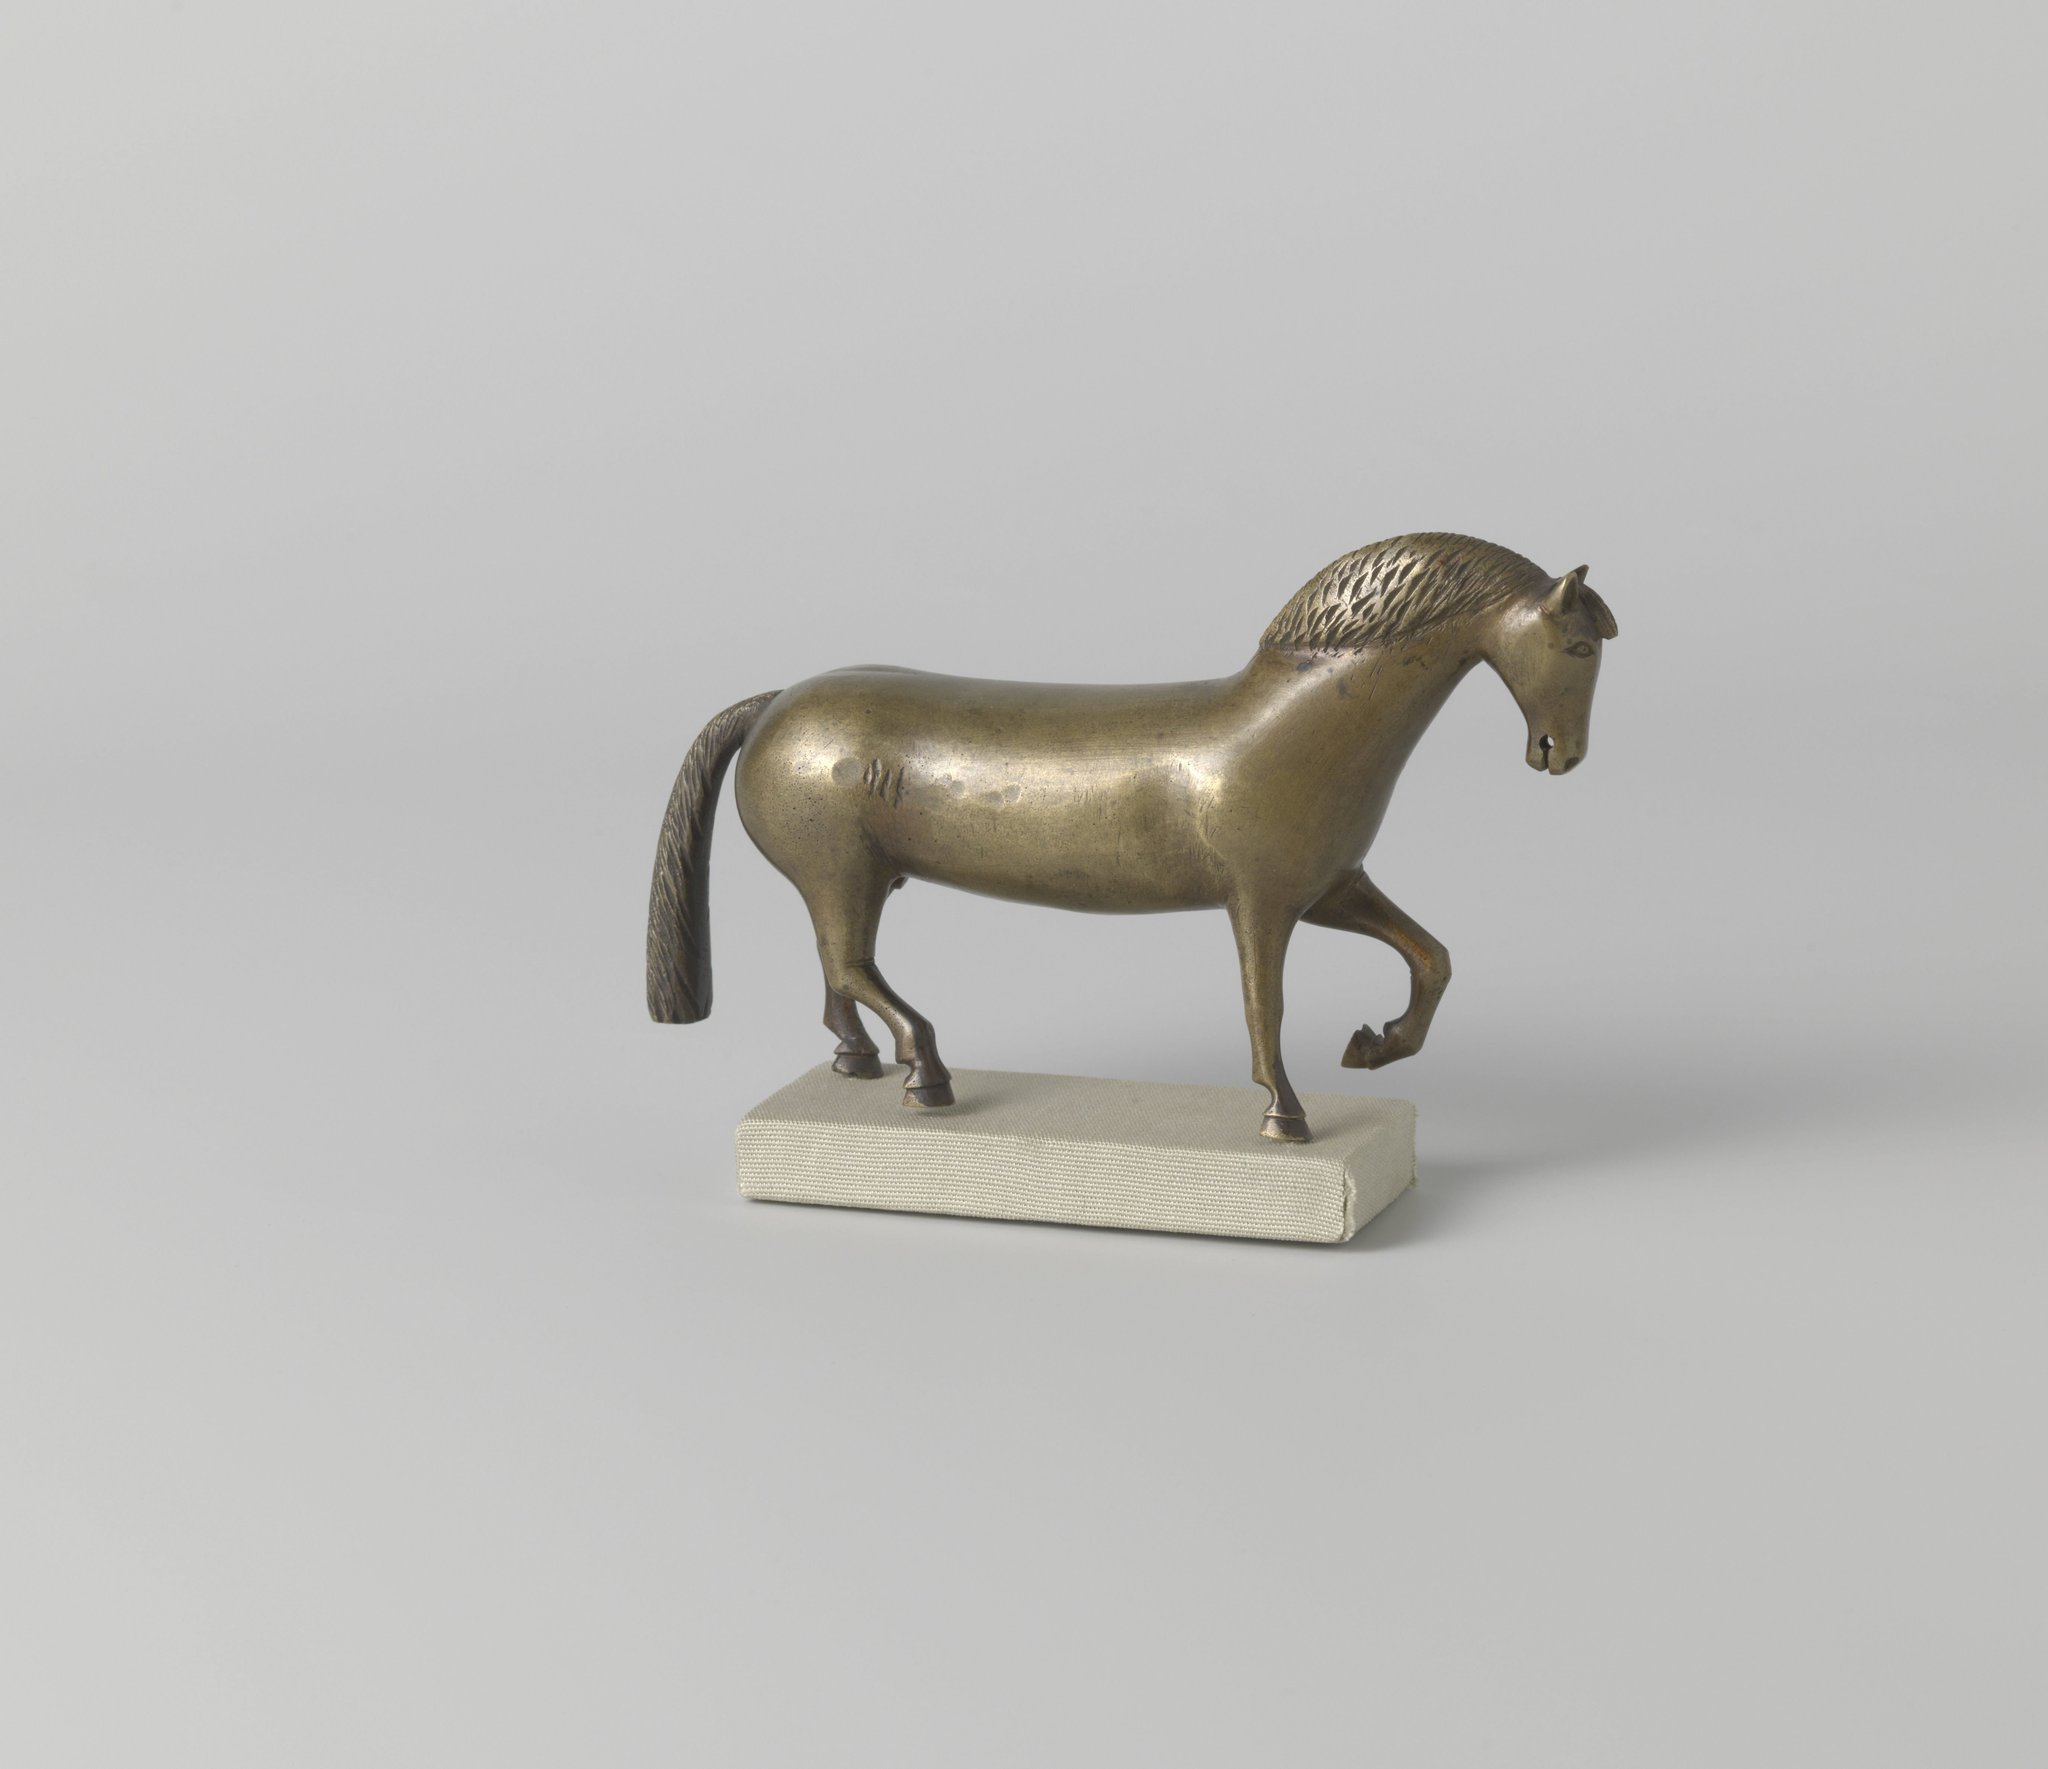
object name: figure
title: Paard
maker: Anonymous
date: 1500-1600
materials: brass, bronze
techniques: casting, metalworking, screwed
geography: western europe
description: Two horses. Bronze or brass. Western Europe, c. 1500 - 1600.